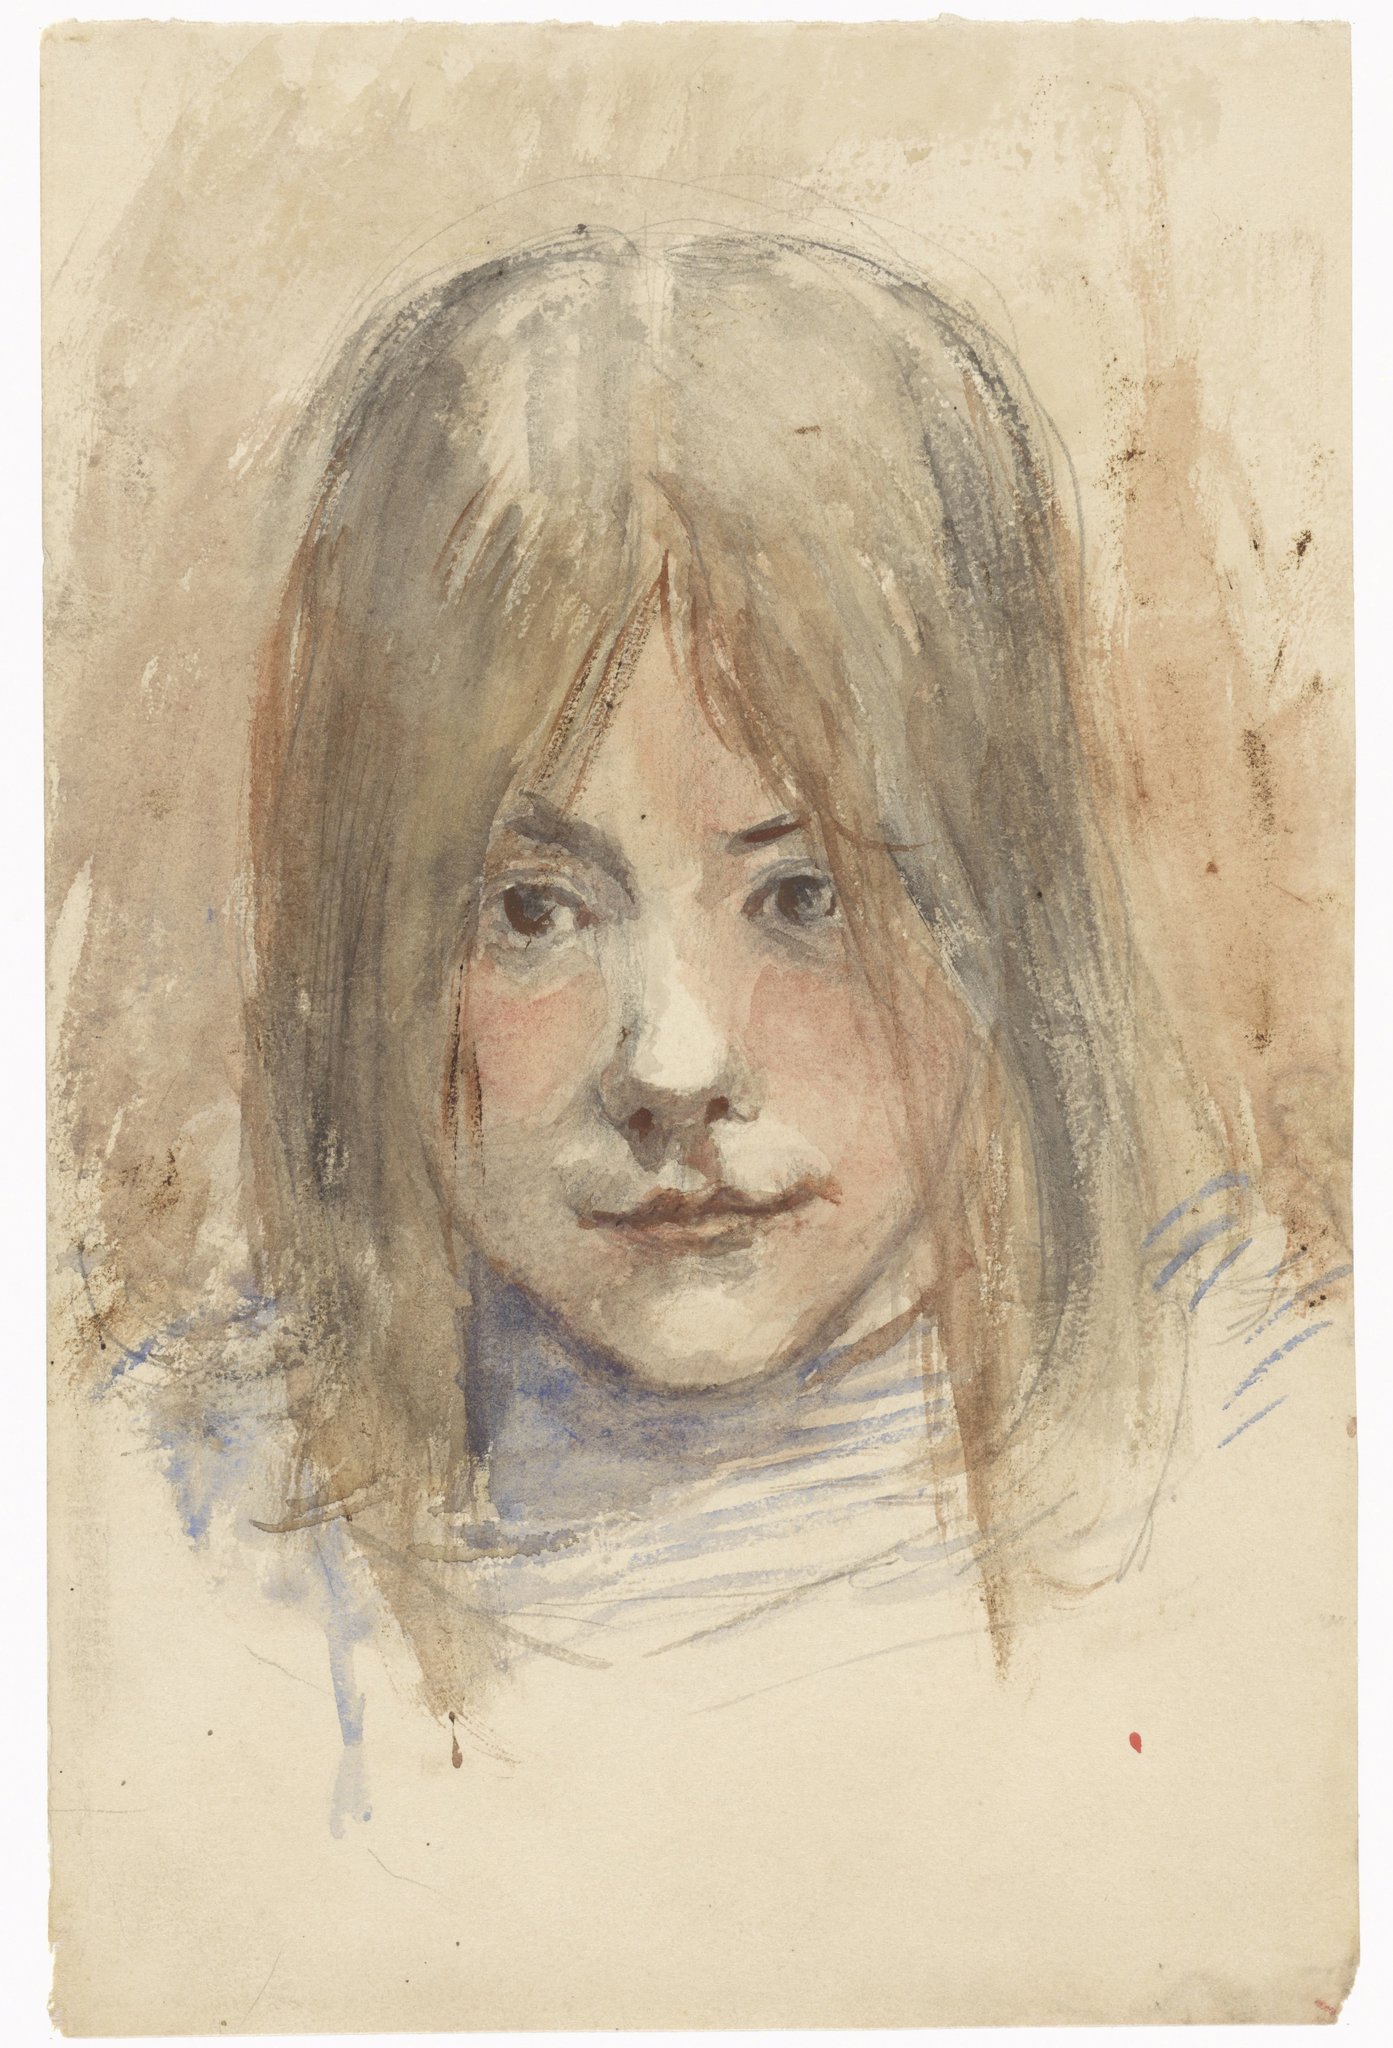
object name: watercolor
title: Portret van een meisje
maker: jozef israëls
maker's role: draughtsman, painter, print maker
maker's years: 1824-1911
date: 1834-1911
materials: paper, pencil, watercolor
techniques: brush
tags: anonymous historical person portrayed alone